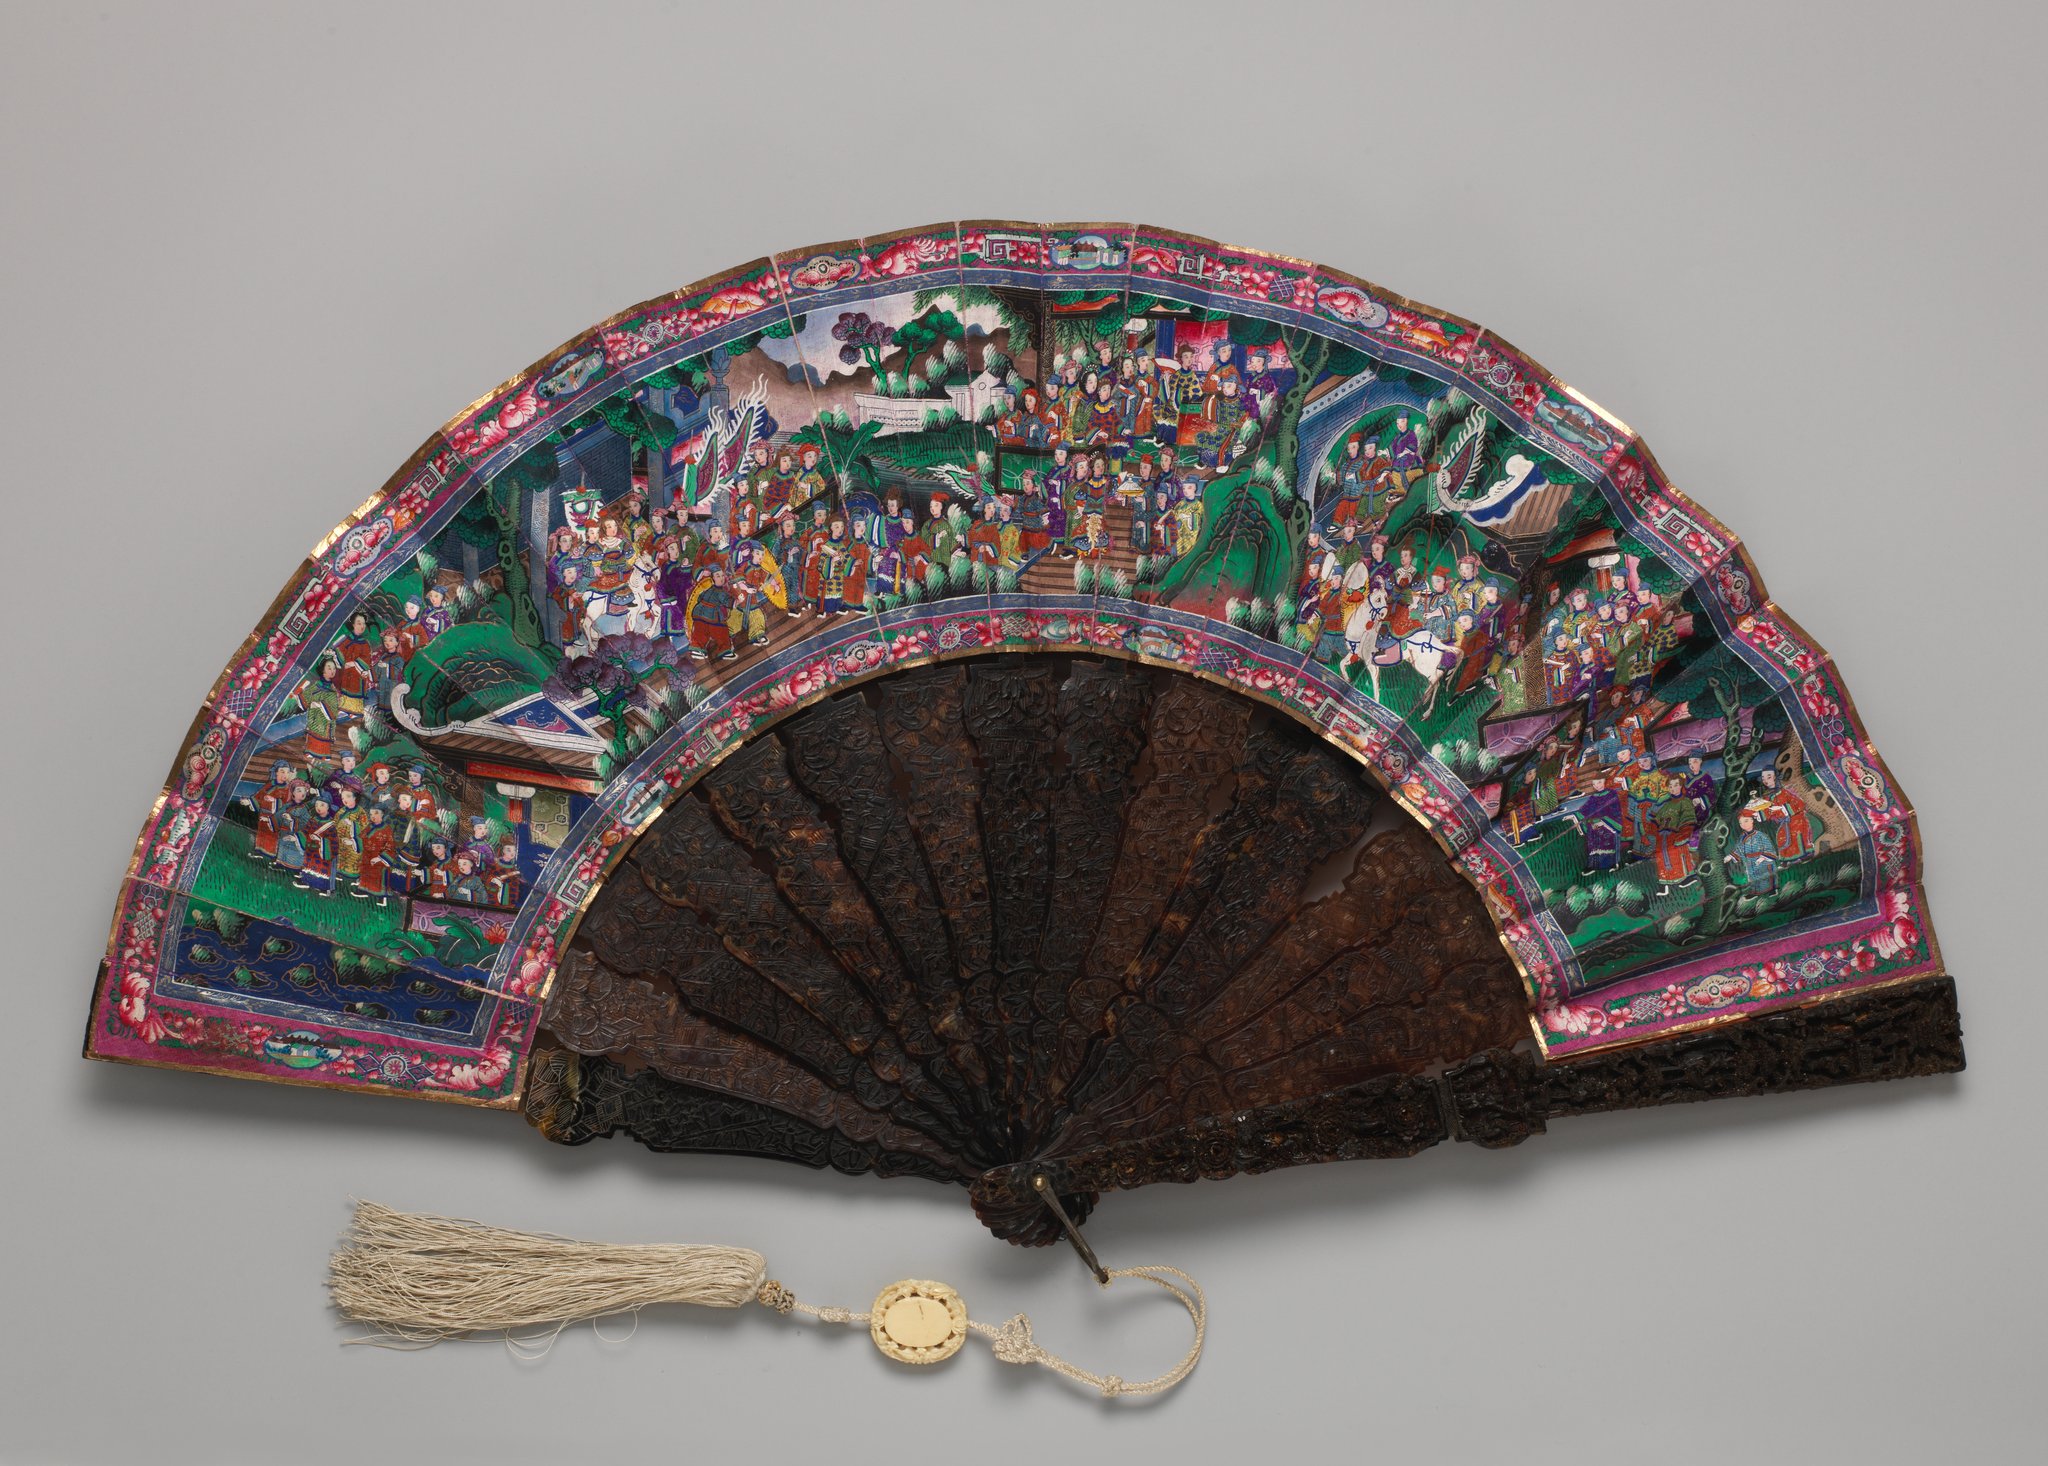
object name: fan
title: Folding Fan with Scene of Figures in a Courtyard Garden and a Stately Procession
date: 1801-1900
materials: ivory, paper, silk, shell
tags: men,women,horses